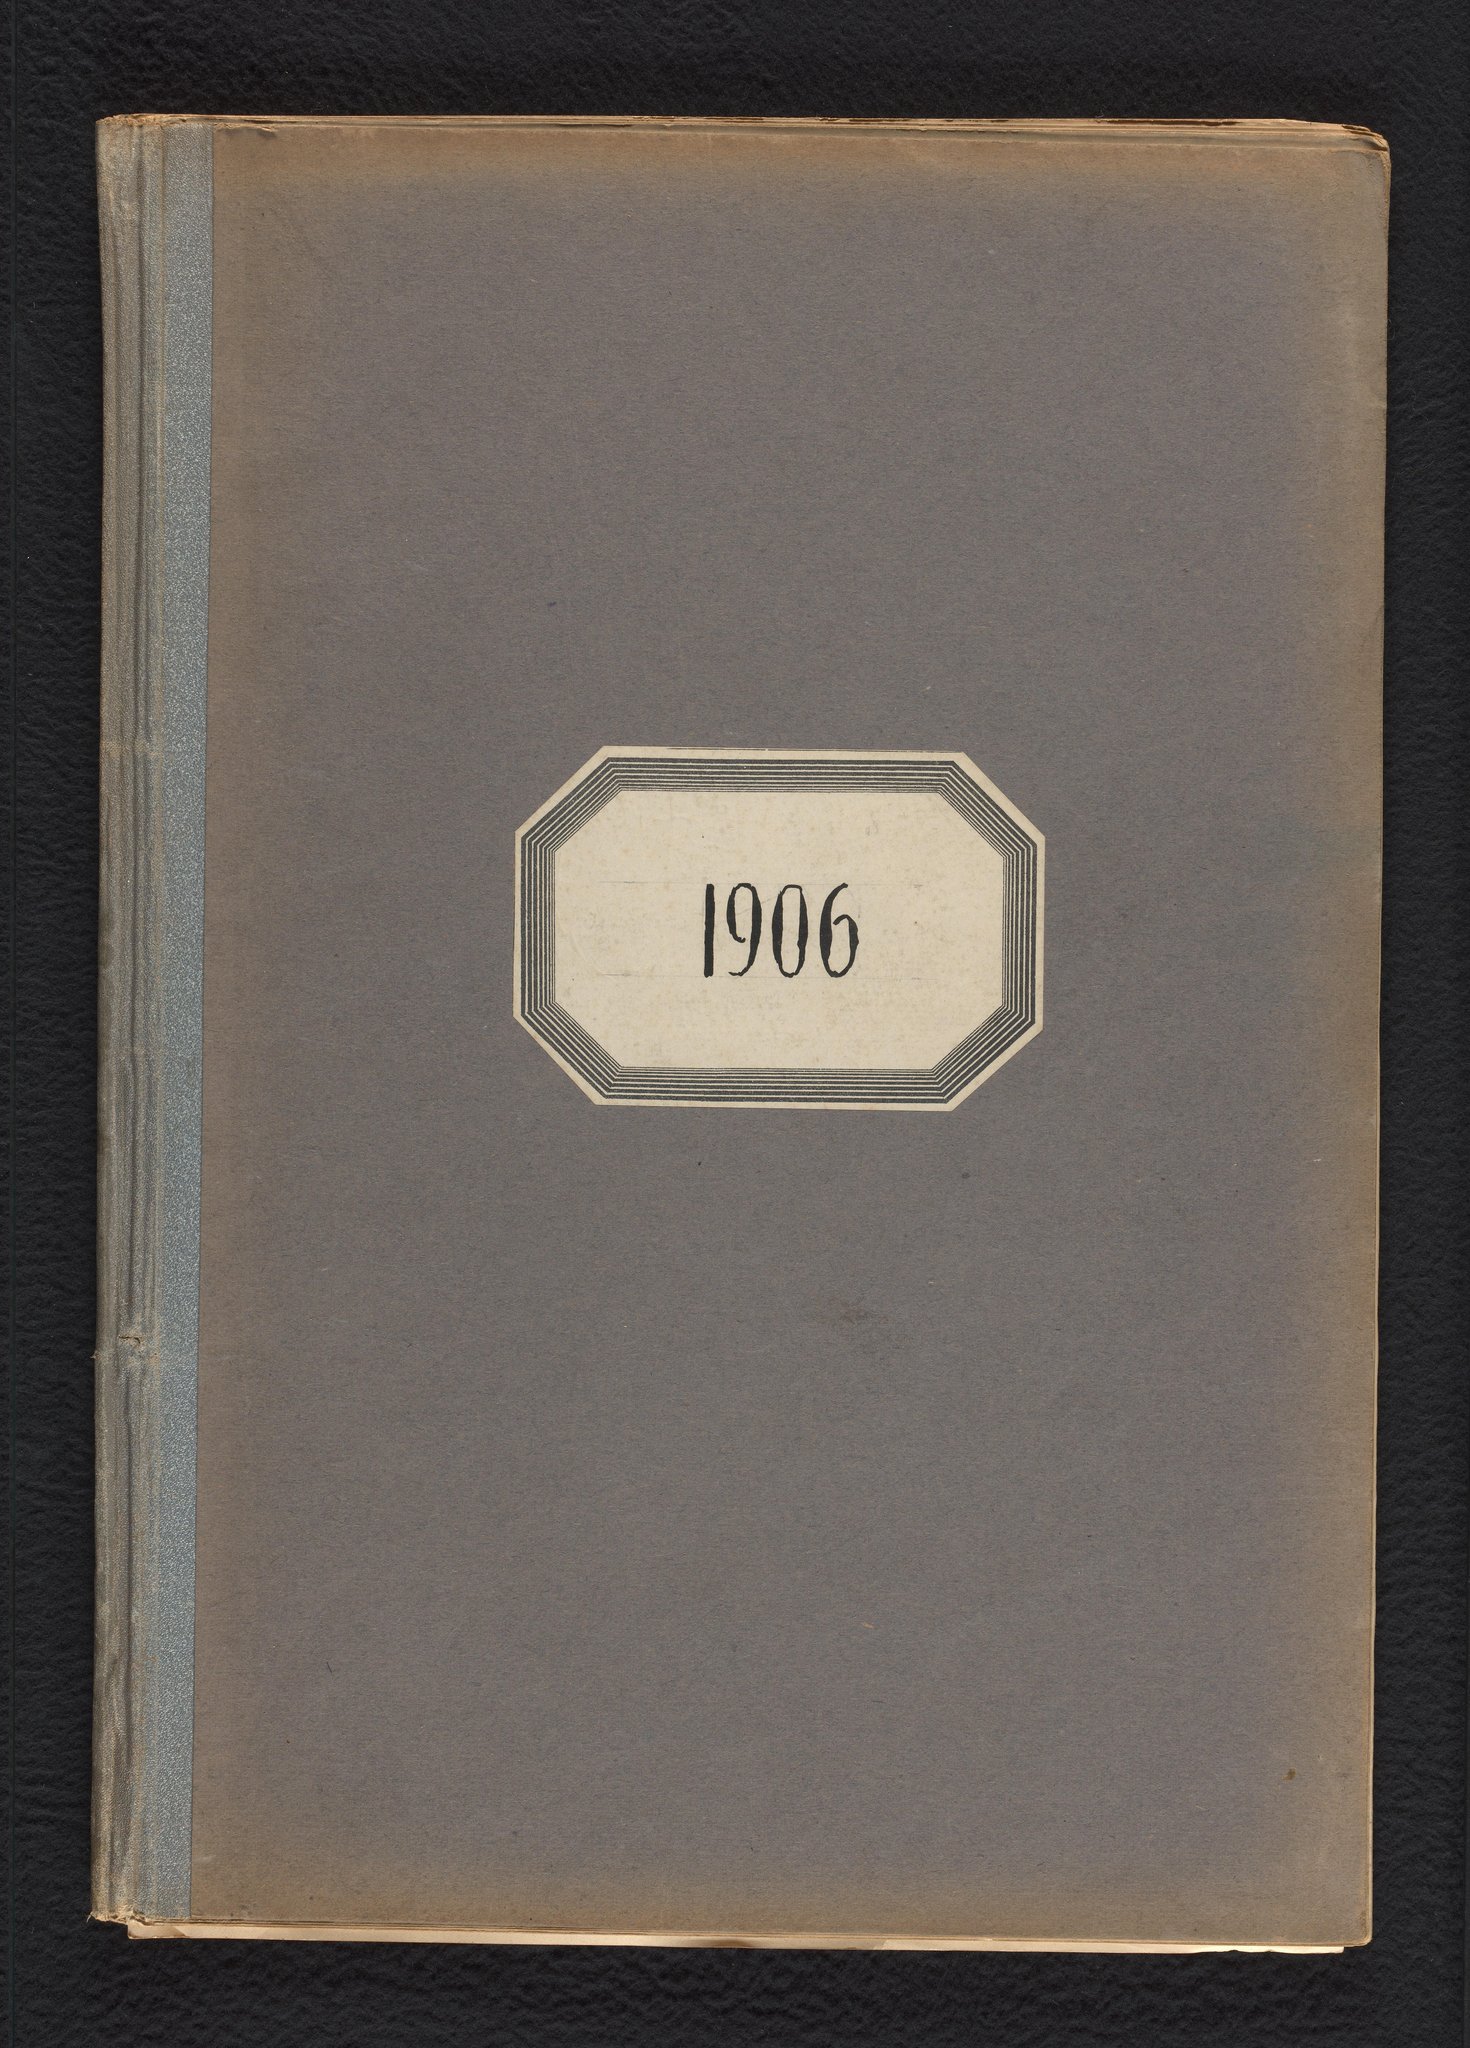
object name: cartoon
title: Spotprenten uit 'De Amsterdammer' van het jaar 1906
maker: johan braakensiek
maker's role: draughtsman, print maker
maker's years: 1858-1940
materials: paper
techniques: lithograph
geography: netherlands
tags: political caricatures and satires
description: Bundel van 52 spotprenten van Braakensiek gepubliceerd als bijvoegsel bij 'De Amsterdammer' in het jaar 1906. Bundel geplakt in slappe omslag van grijsgroen karton met handgeschreven etiket '1906'.